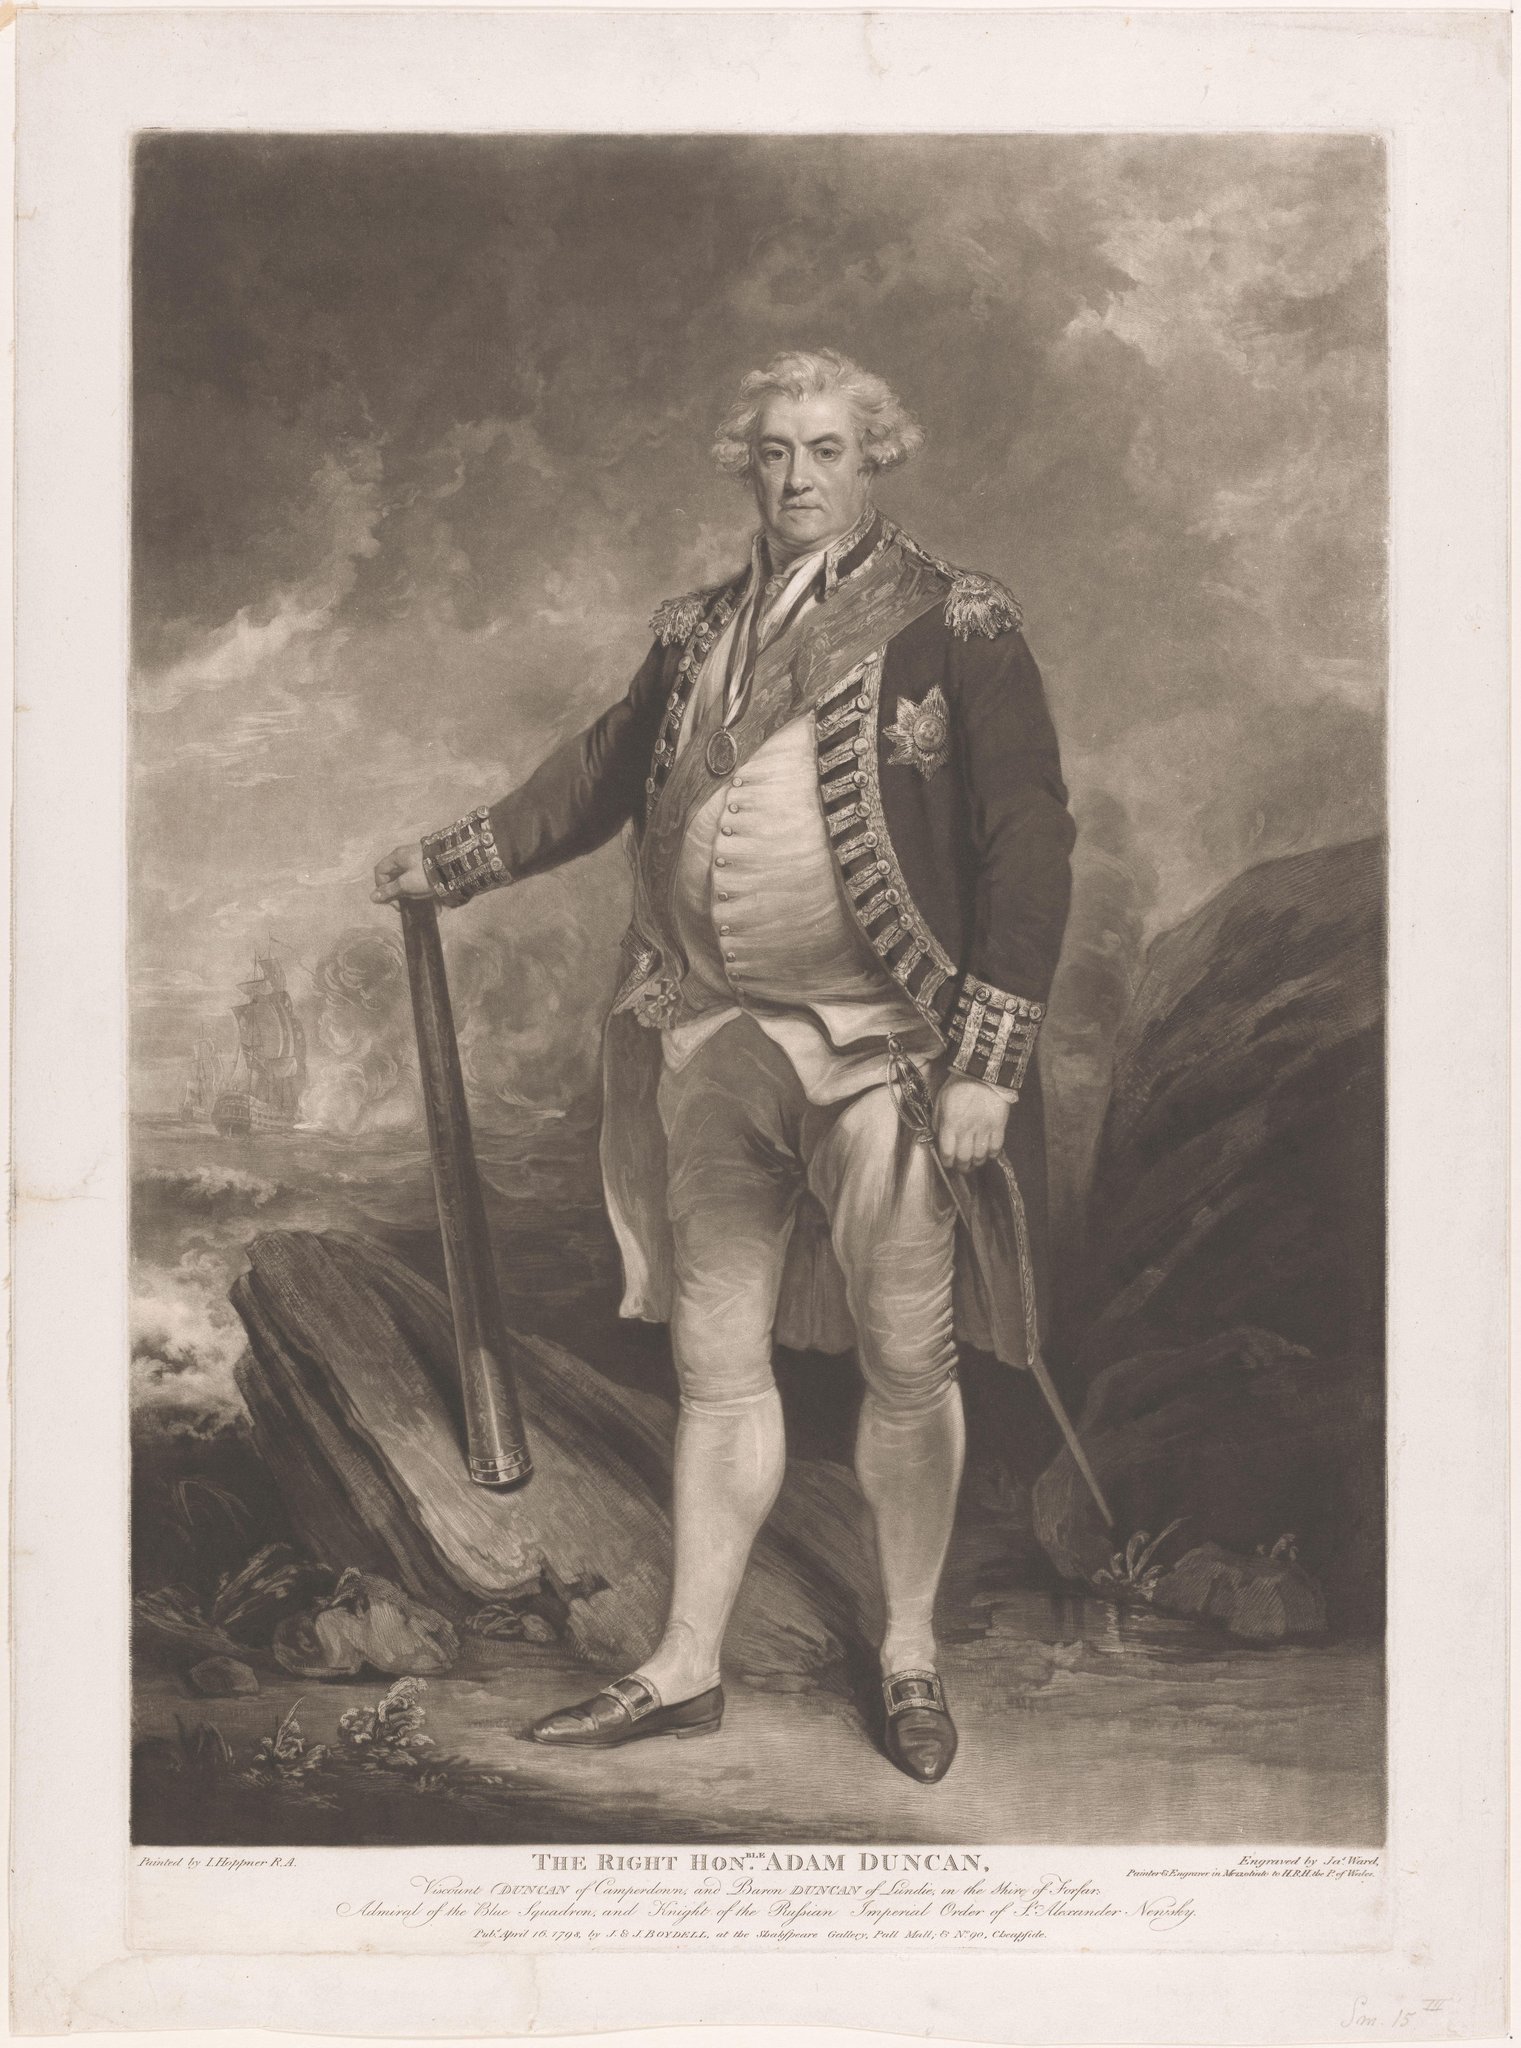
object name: print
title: Portret van Adam Duncan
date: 1798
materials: paper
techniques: etching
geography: london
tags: adam duncan (burggraaf van duncan), historical persons, politician, e.g. party leader